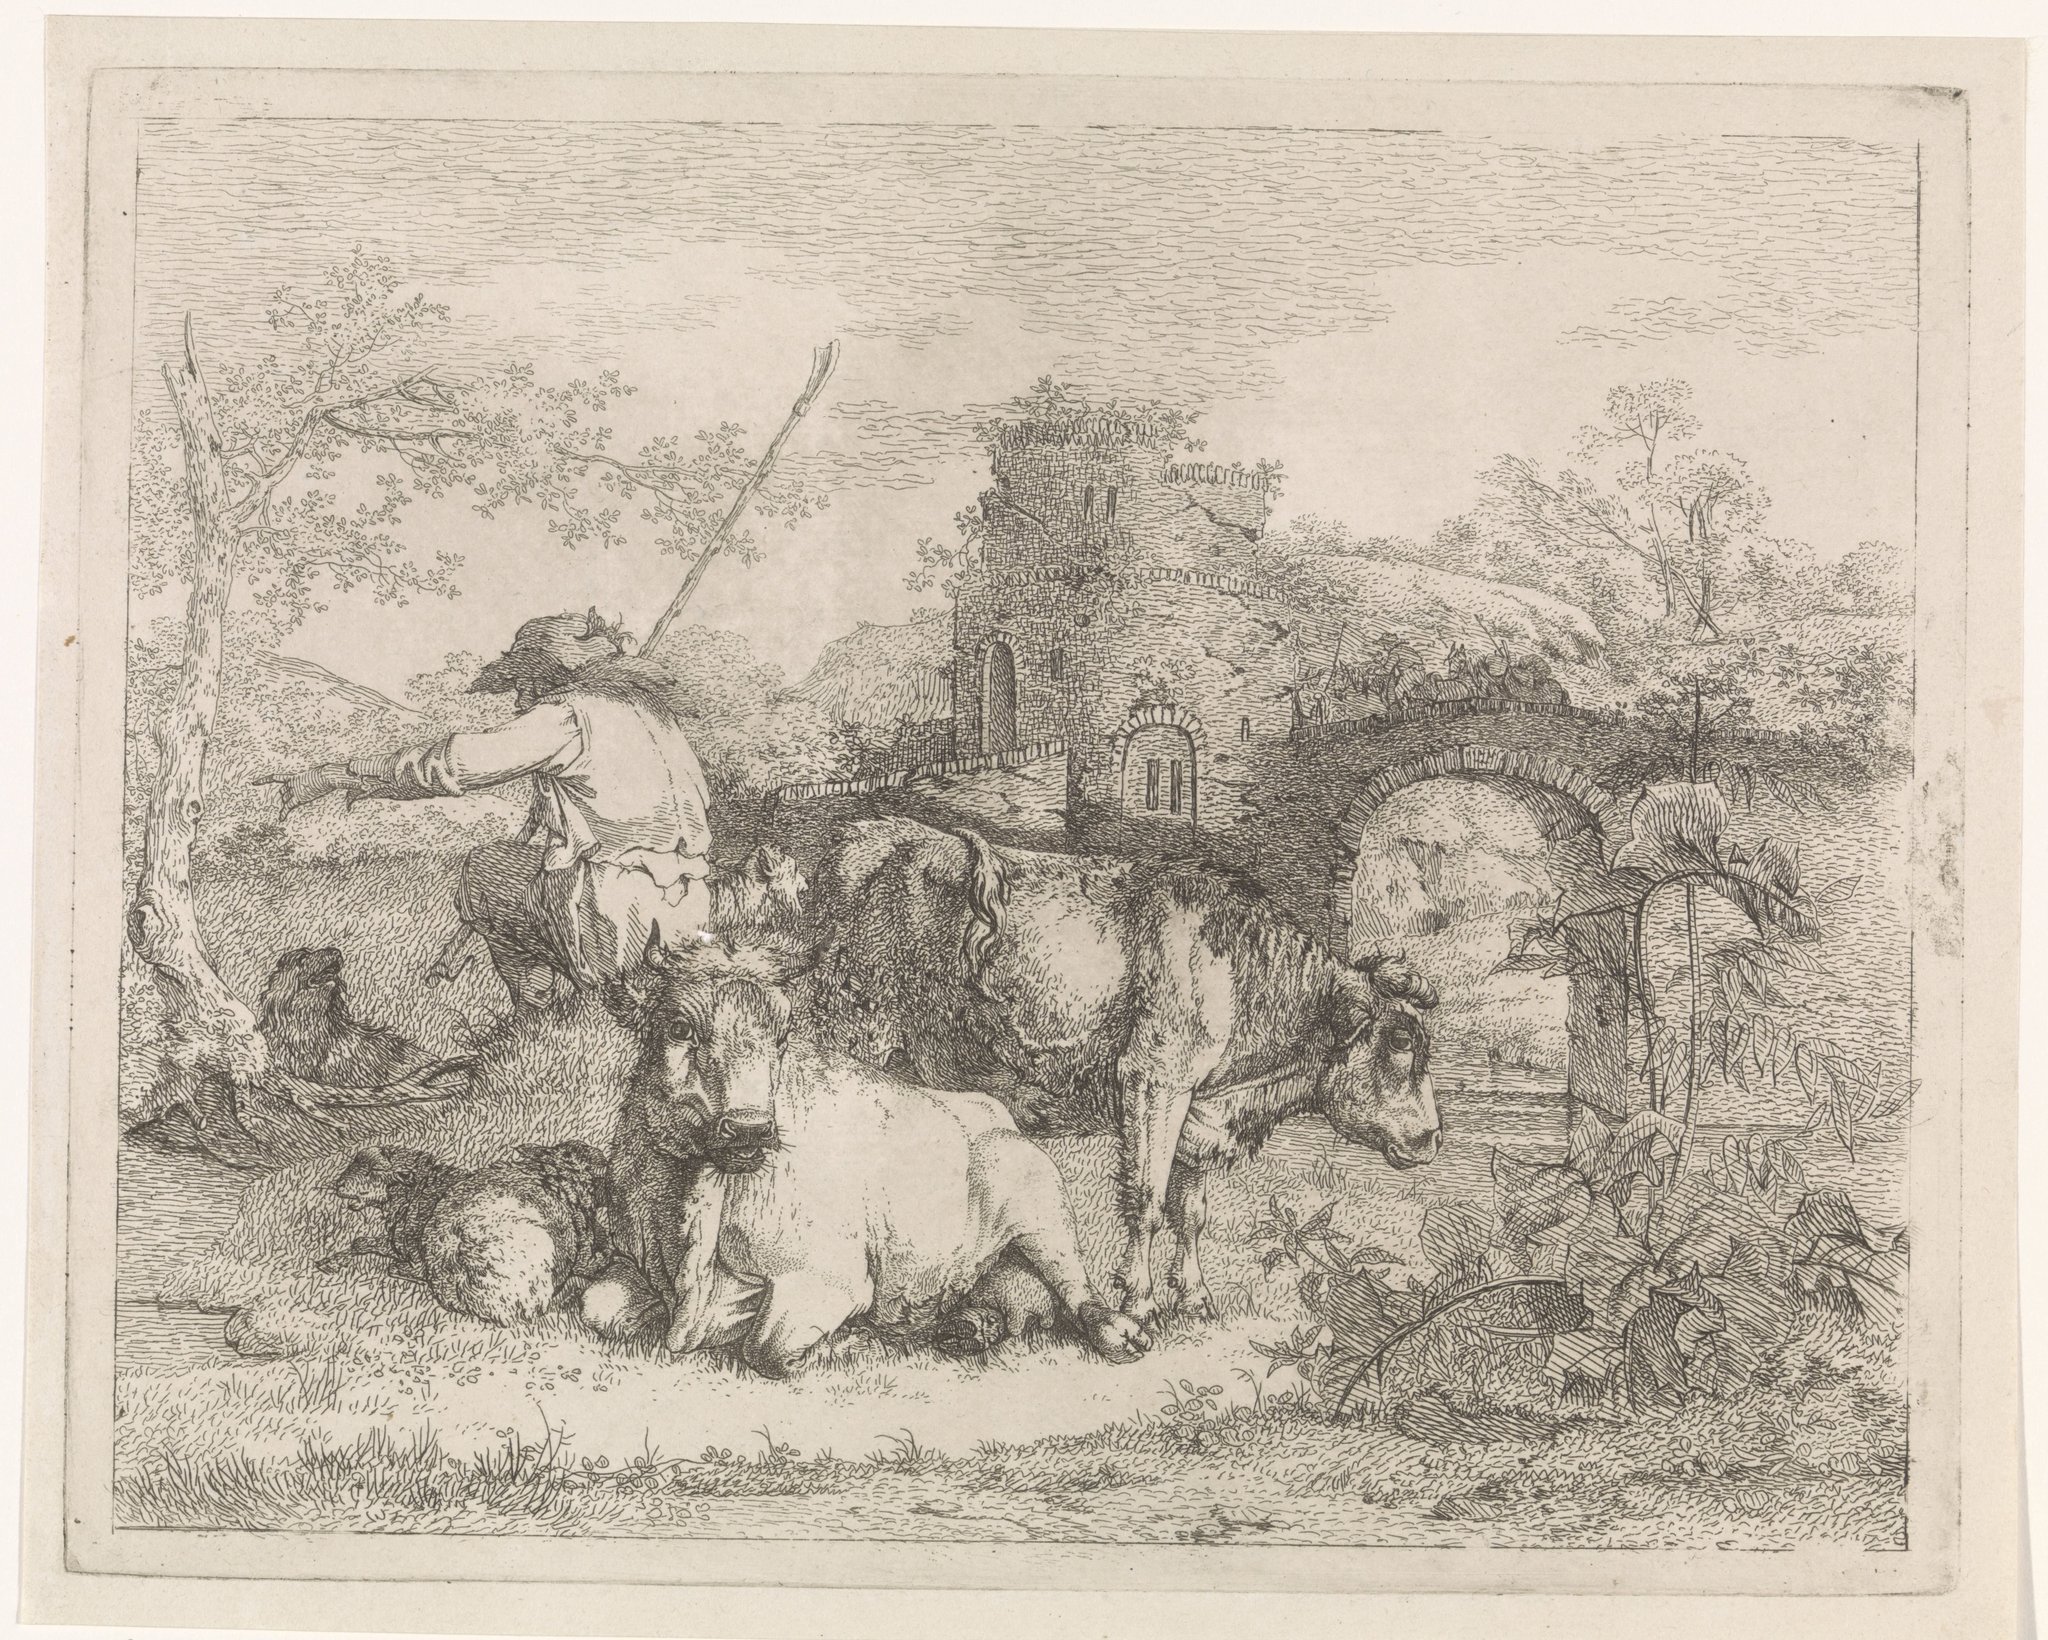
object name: print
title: Herder met zijn kudde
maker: barend hendrik thier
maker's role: draughtsman, print maker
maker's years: 1743-1811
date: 1755-1811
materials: paper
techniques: etching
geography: netherlands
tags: cow, herding, herdsman, herdswoman, shepherd, shepherdess, cowherd, etc., dog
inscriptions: collector's mark: Lugt 2228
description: Een herder zit bij twee koeien en twee schapen op een heuveltje en wijst zijn hond op iets in de verte.